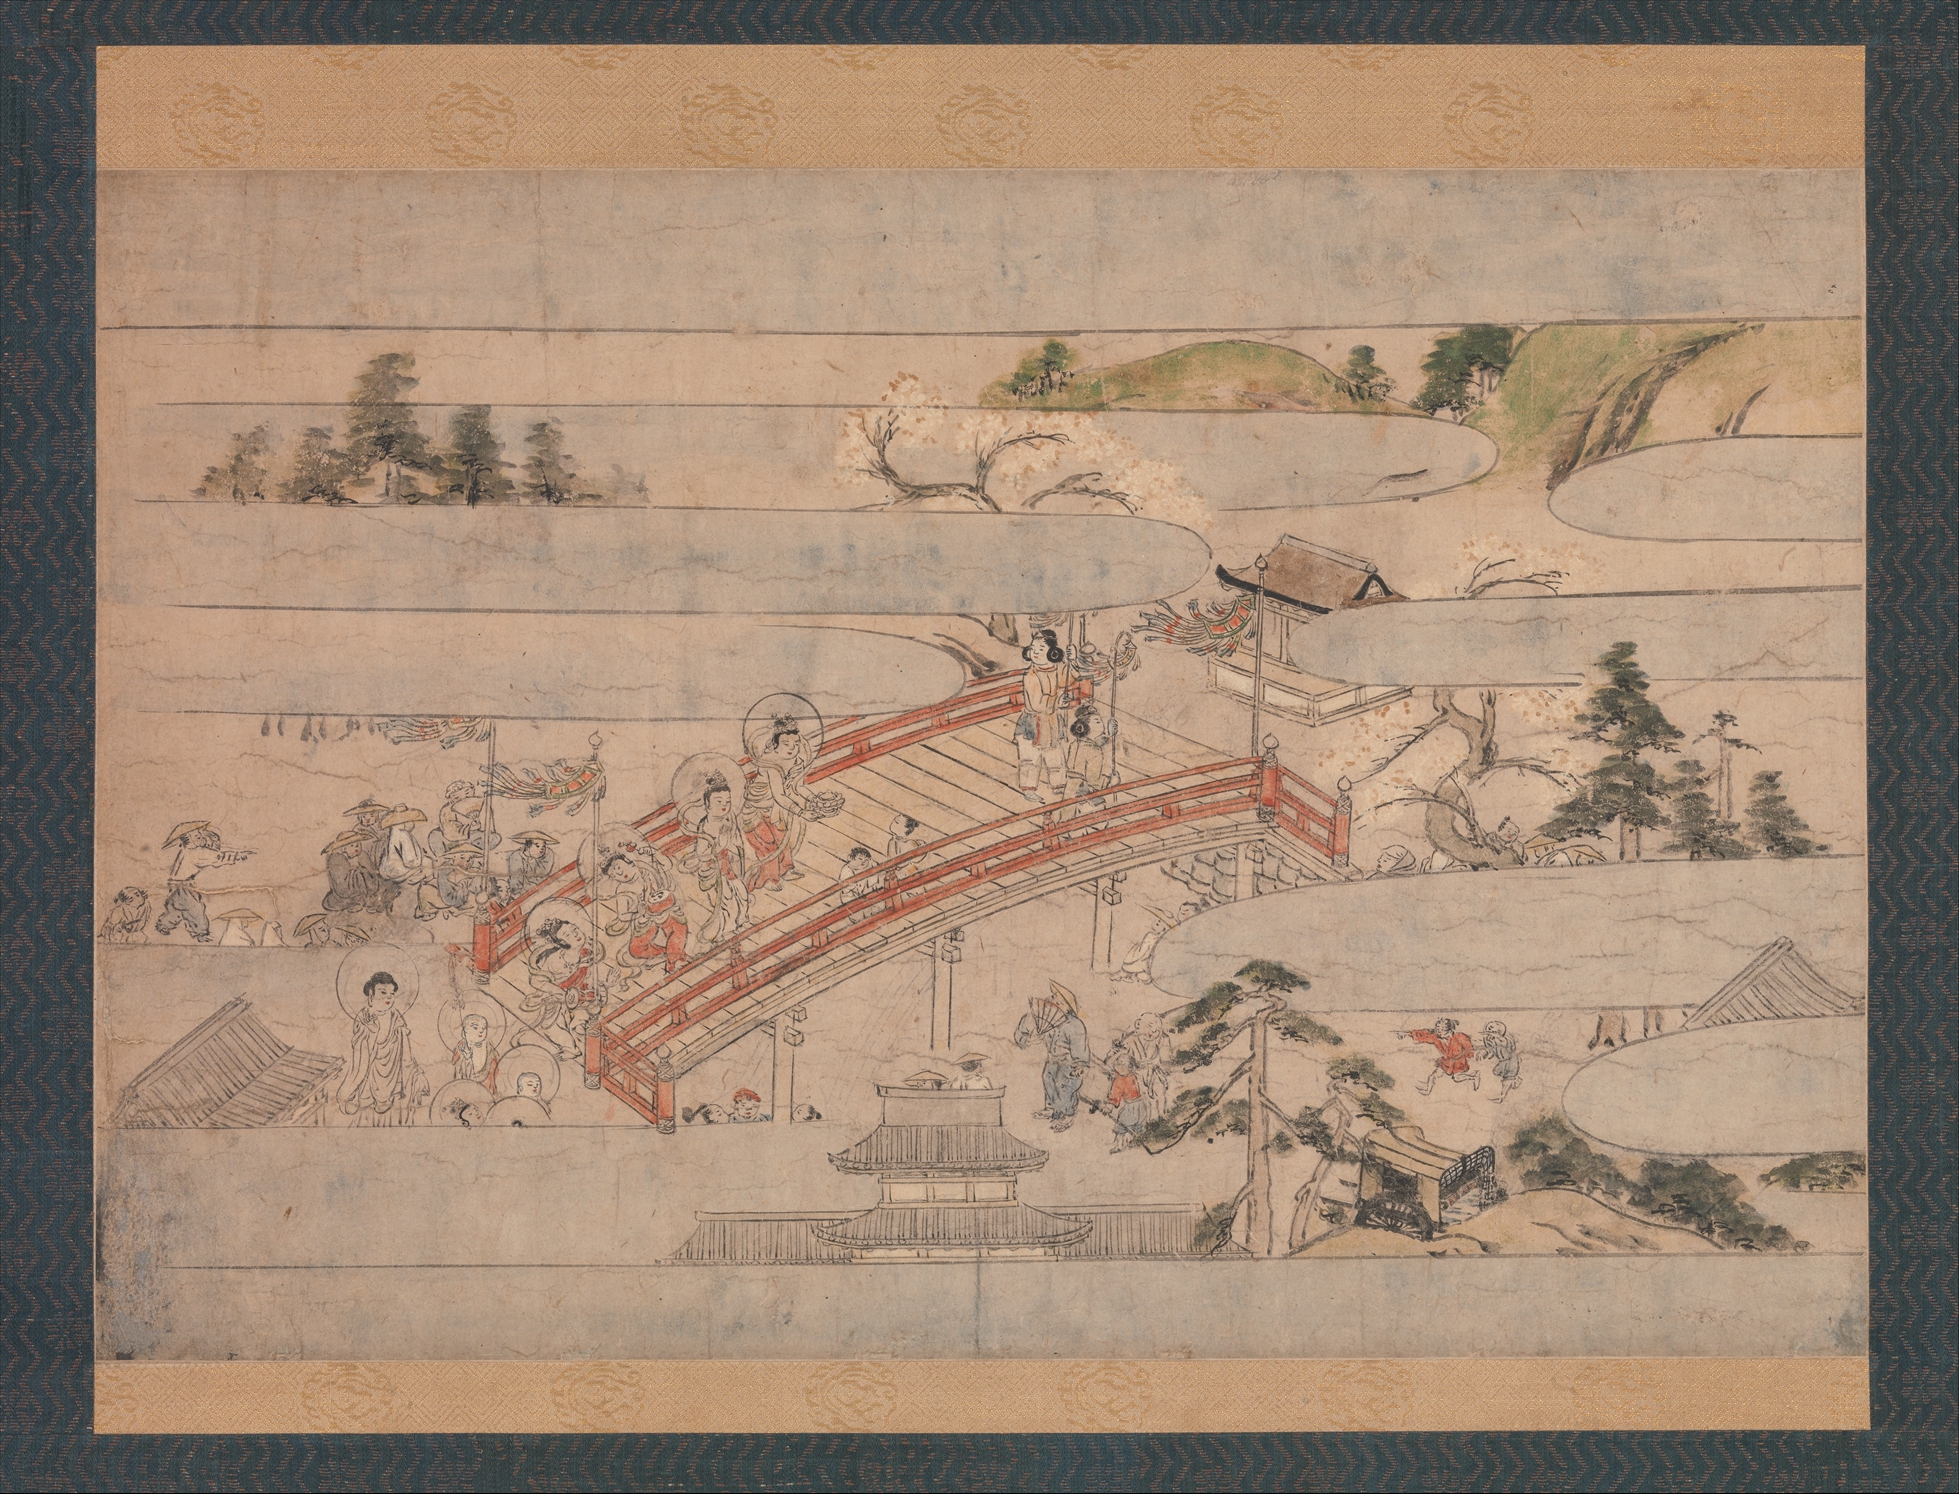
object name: hanging scroll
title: The Final Scene from A Long Tale for an Autumn Night (Aki no yonaga monogatari)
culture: japanese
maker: unidentified artist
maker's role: artist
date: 1400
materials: ink, paper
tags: bridges,landscapes